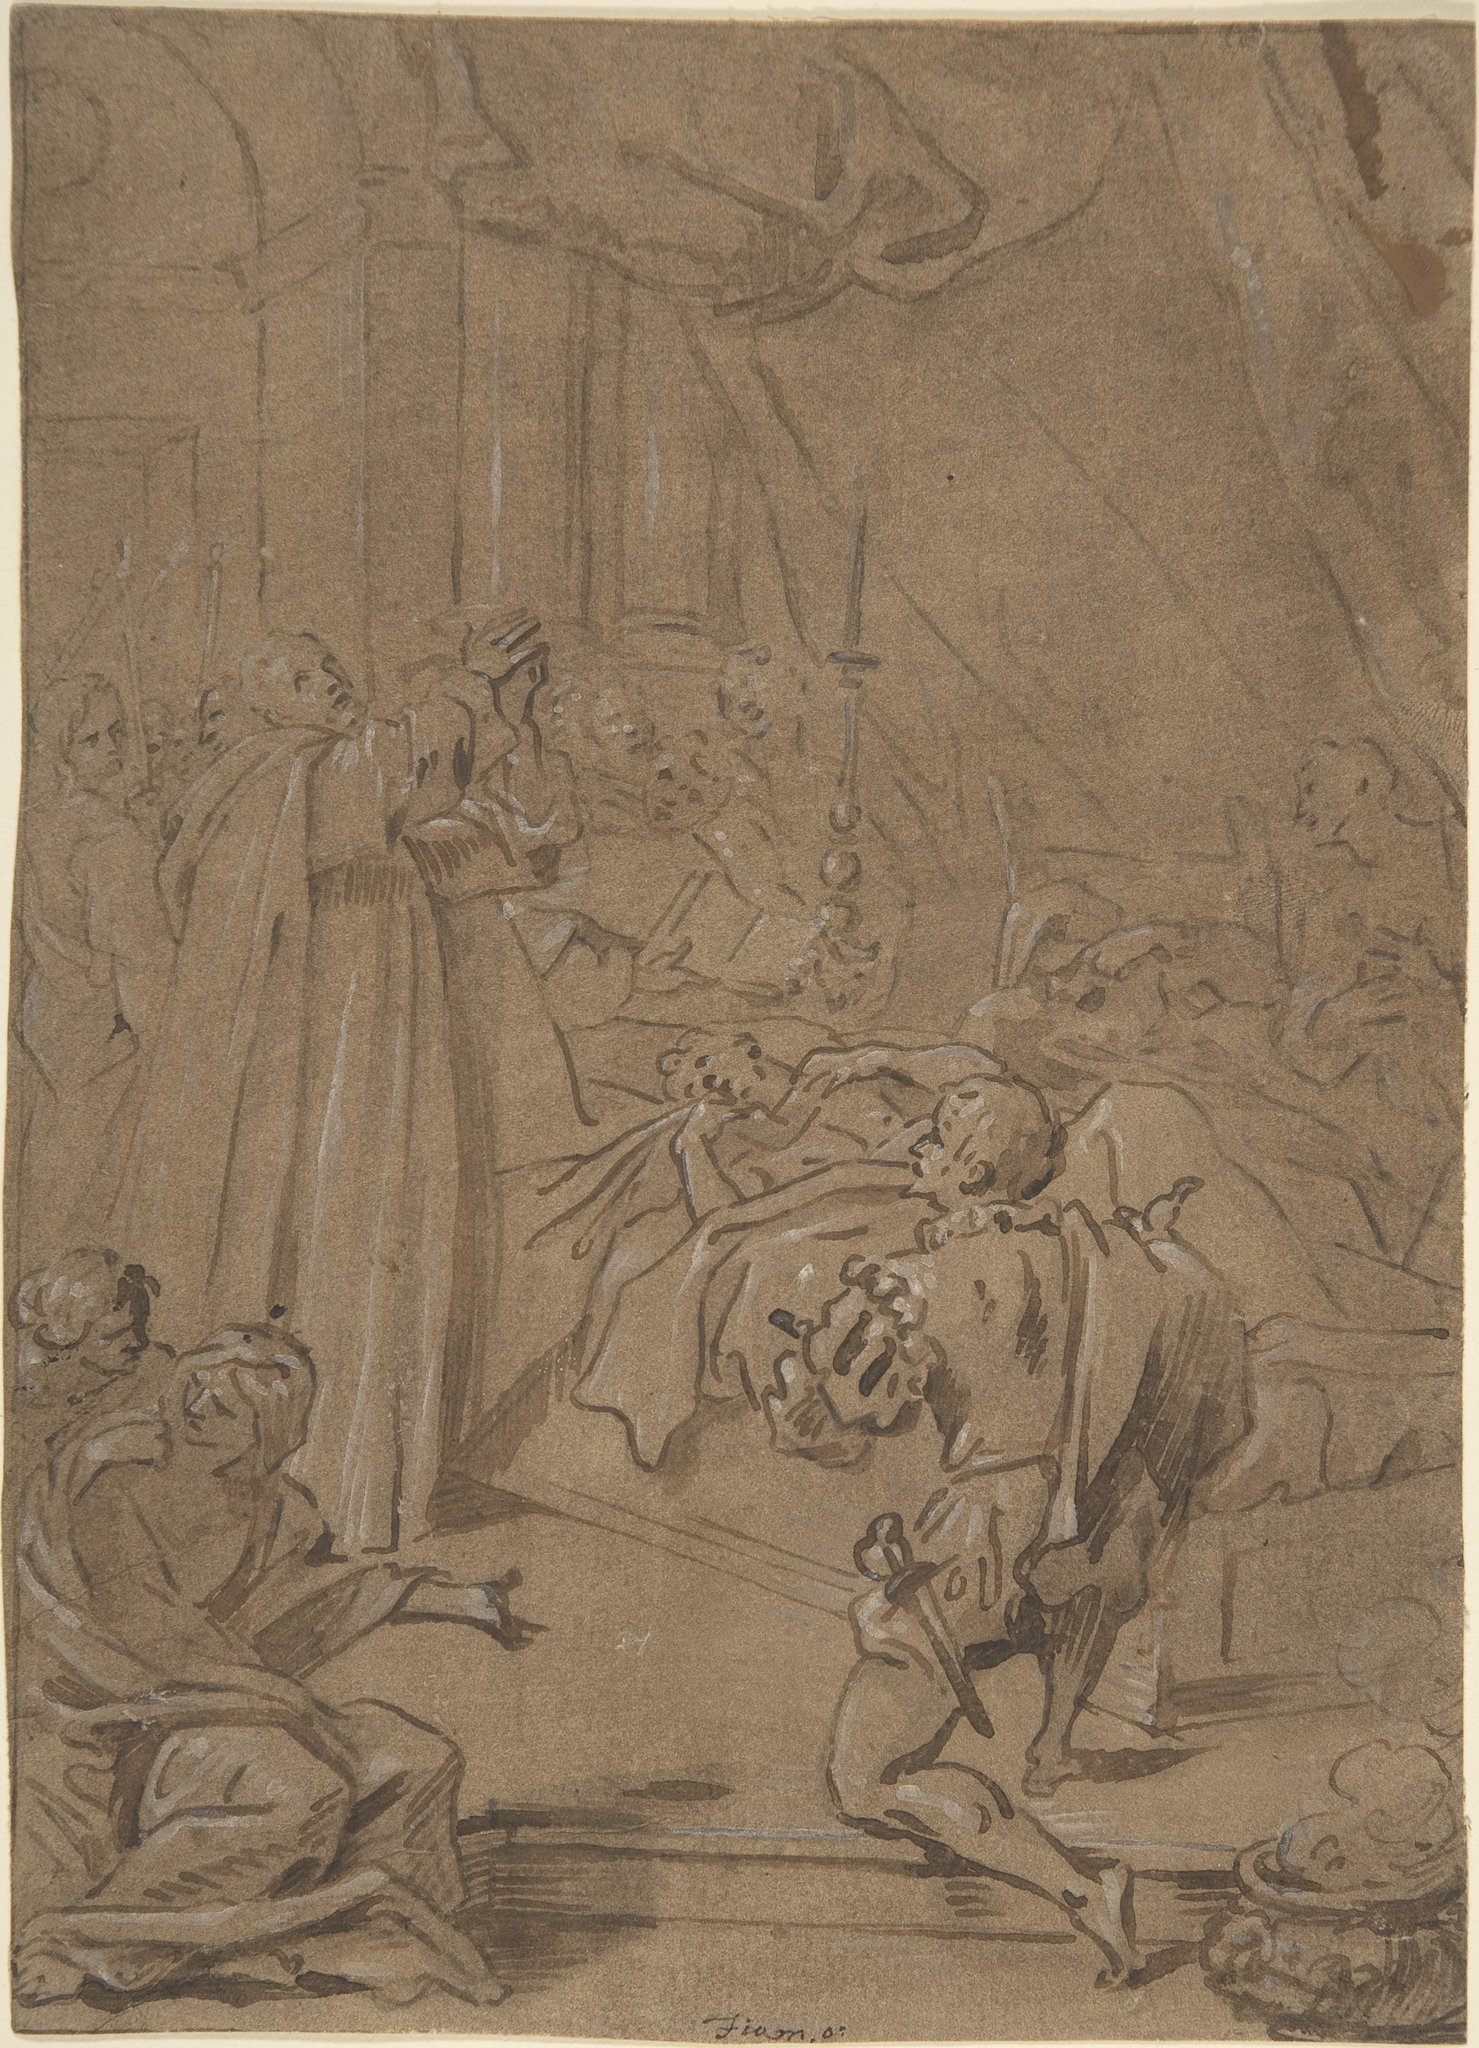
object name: drawing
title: Deathbed Scene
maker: anonymous, flemish, 17th century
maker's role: artist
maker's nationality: flemish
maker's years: 1600-1700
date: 1601-1700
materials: ink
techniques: brush, heightening, pen, wash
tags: sadness,men,women,death